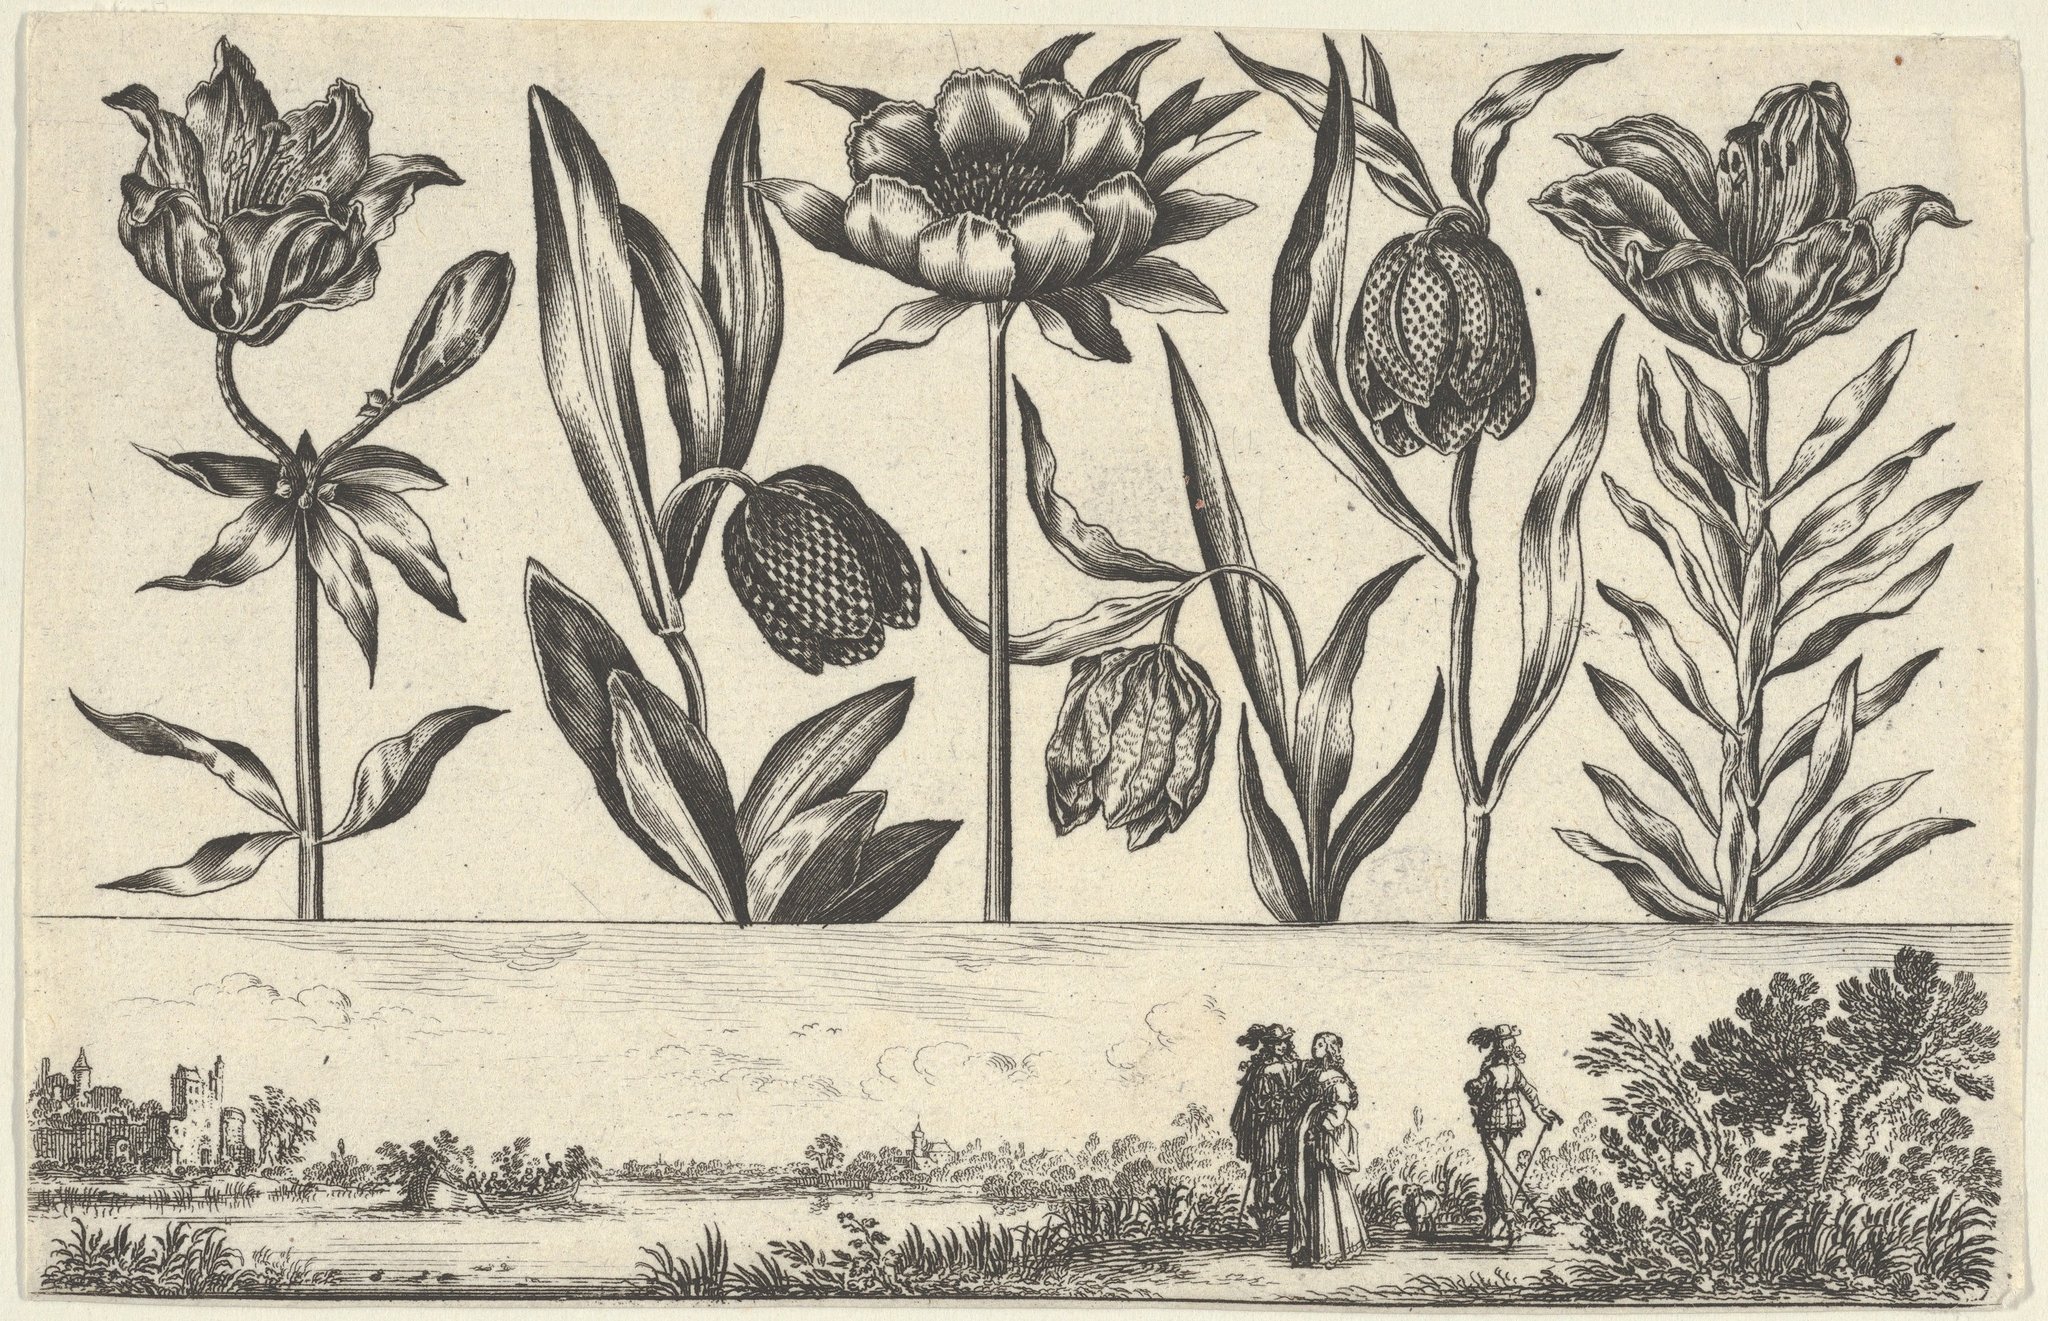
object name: print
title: Horizontal Panel with a Row of Flowers Above a Frieze with Figures in a Landscape, from "Livre Nouveau de Fleurs Tres-Util"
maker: nicolas cochin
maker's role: artist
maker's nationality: french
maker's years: 1610-1686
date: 1645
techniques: engraving, etching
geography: france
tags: flowers,landscapes